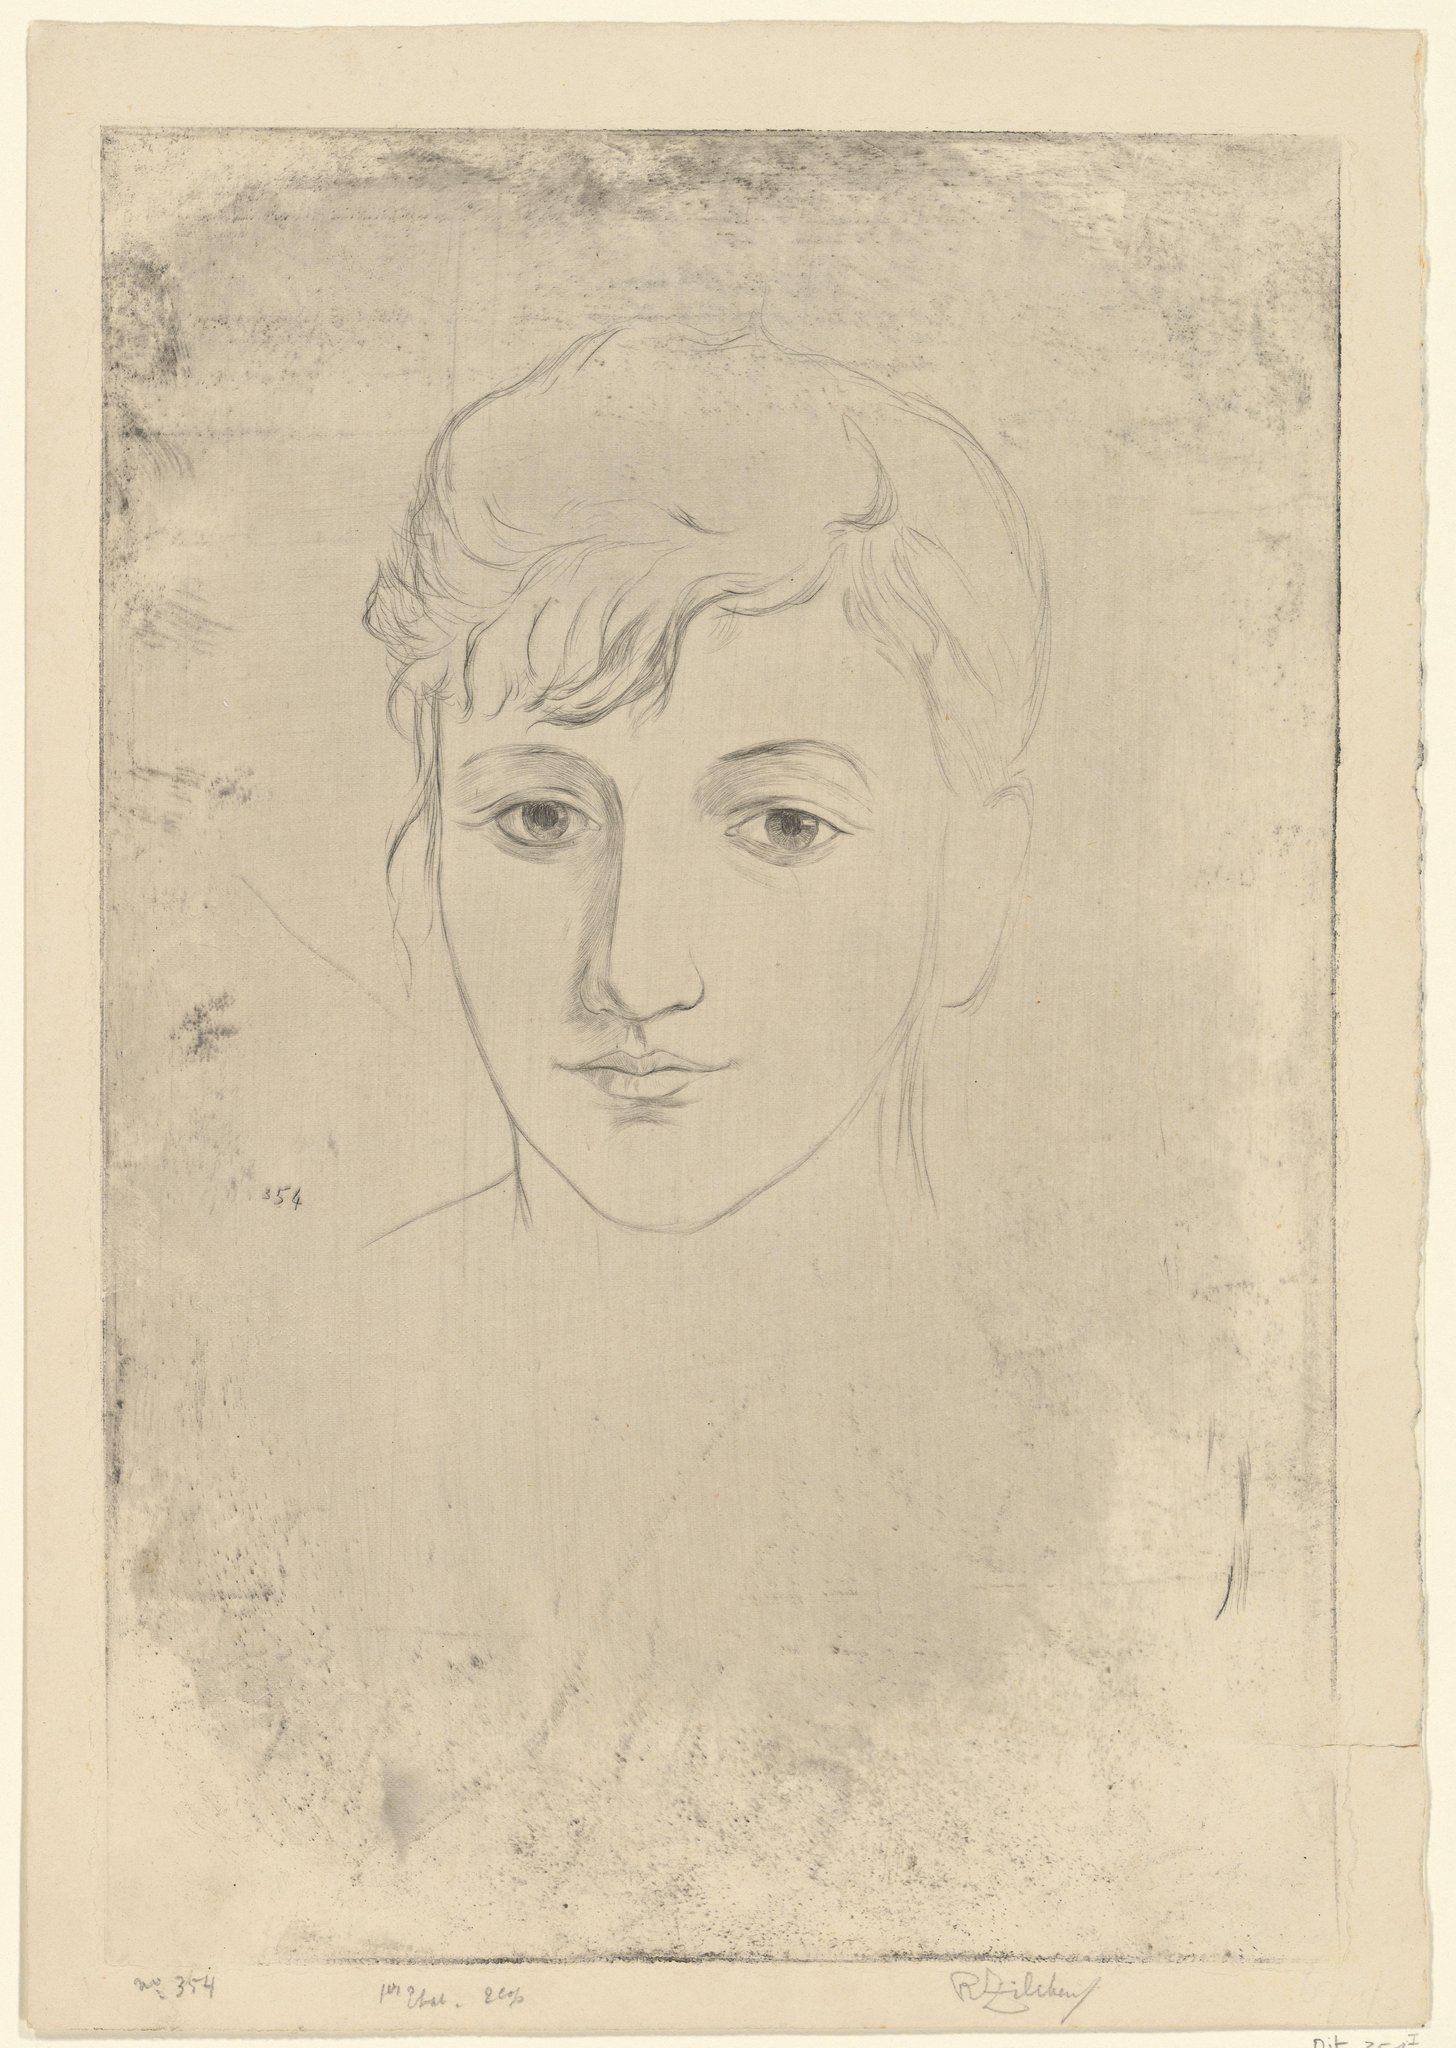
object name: print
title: Gezicht van een jonge vrouw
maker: philip zilcken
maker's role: draughtsman, painter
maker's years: 1857-1930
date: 1890-1930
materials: paper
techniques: drypoint, intaglio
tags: adolescent, young woman, maiden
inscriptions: collector's mark: Lugt 2228, collector's mark: Lugt 2760